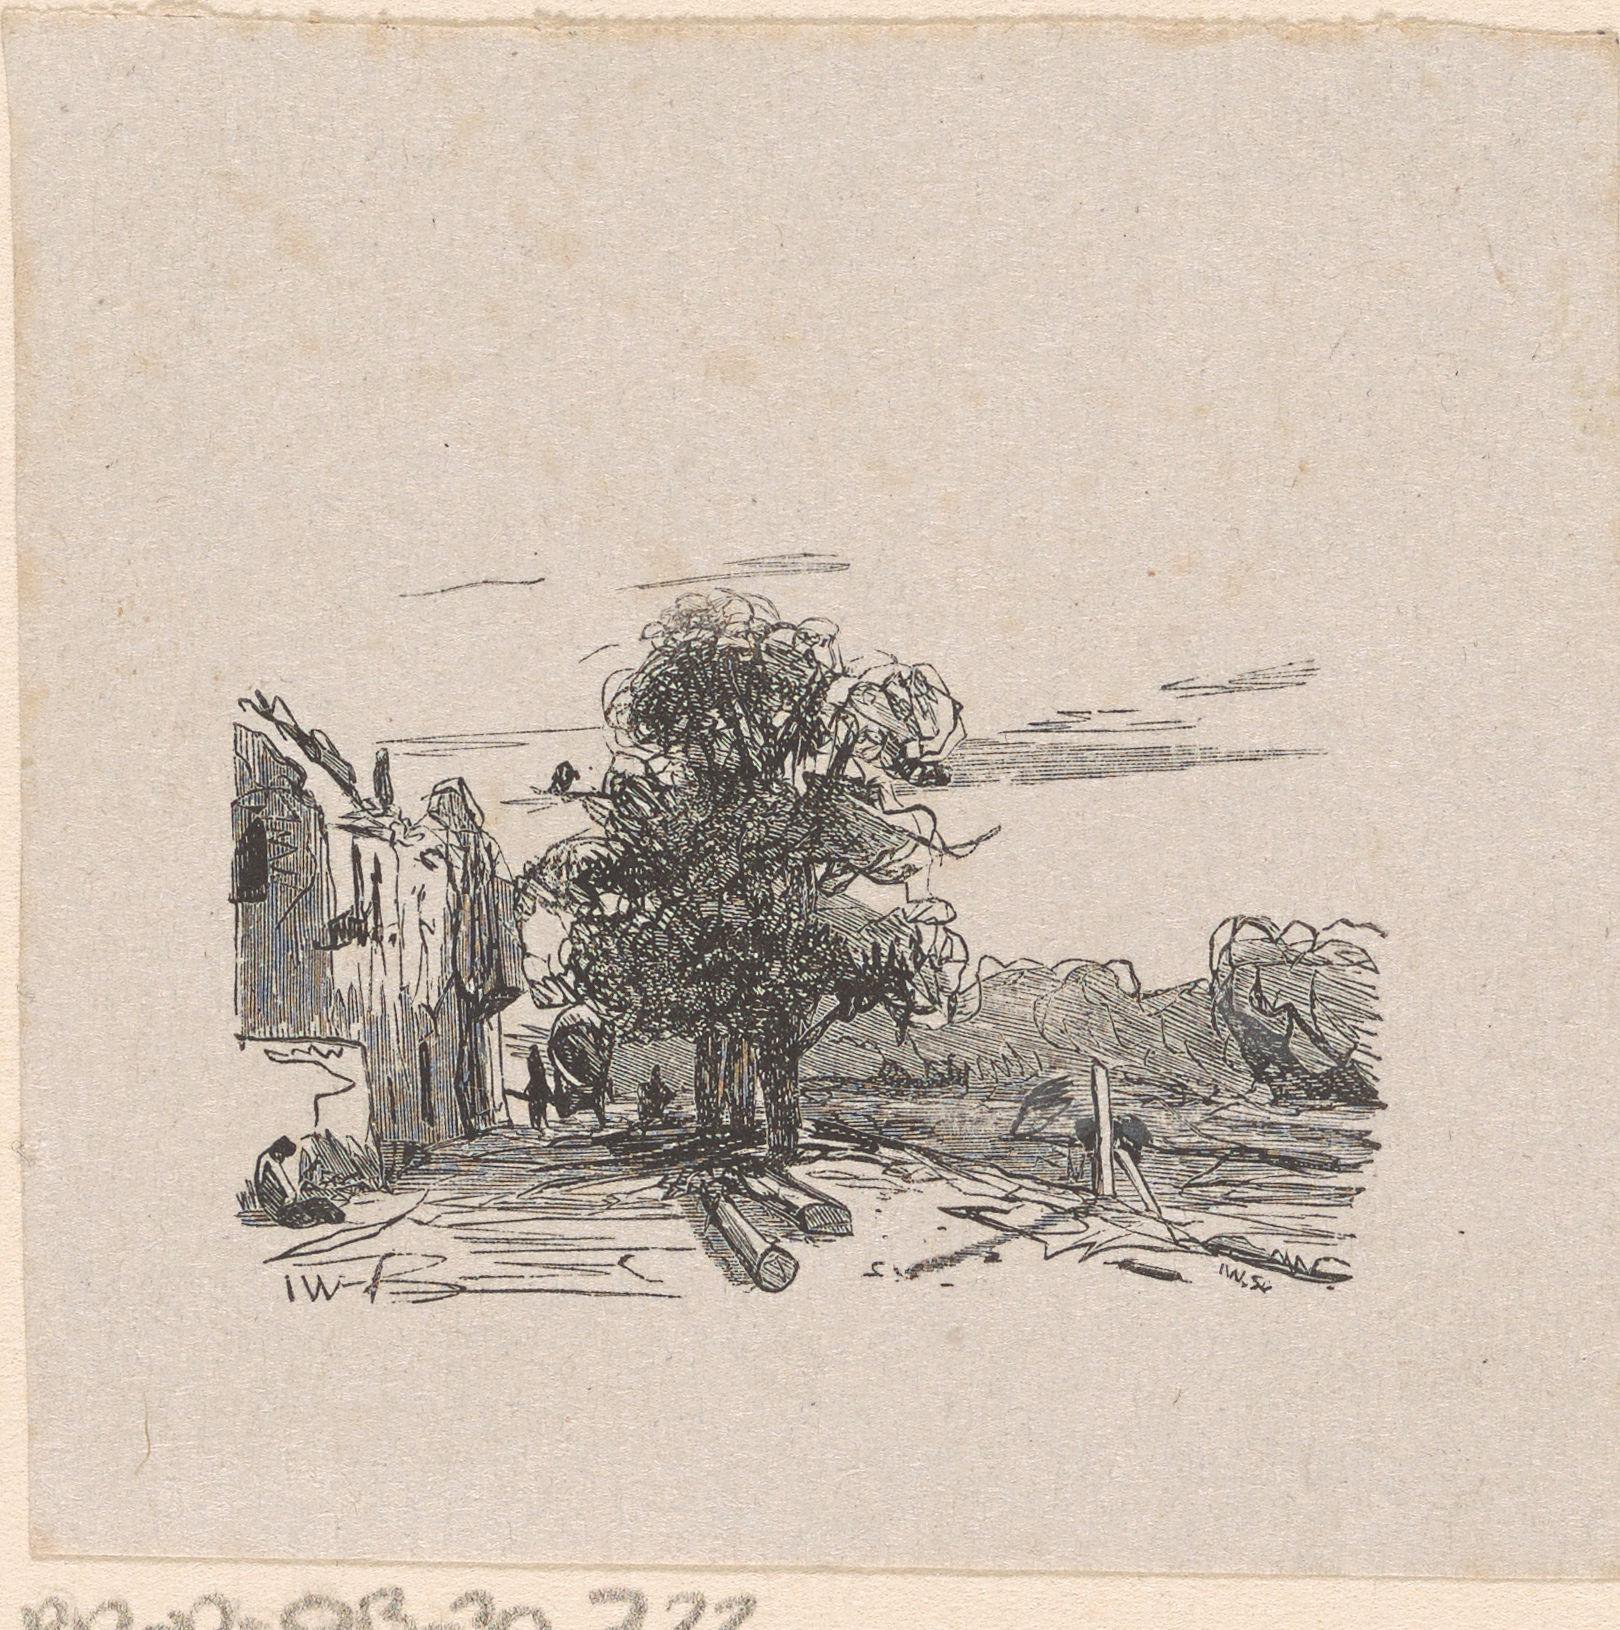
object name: print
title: Landschap met een bomenrij en huizen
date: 1836-1912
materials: paper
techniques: engraving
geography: netherlands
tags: city-view, and landscape with man-made constructions, trees